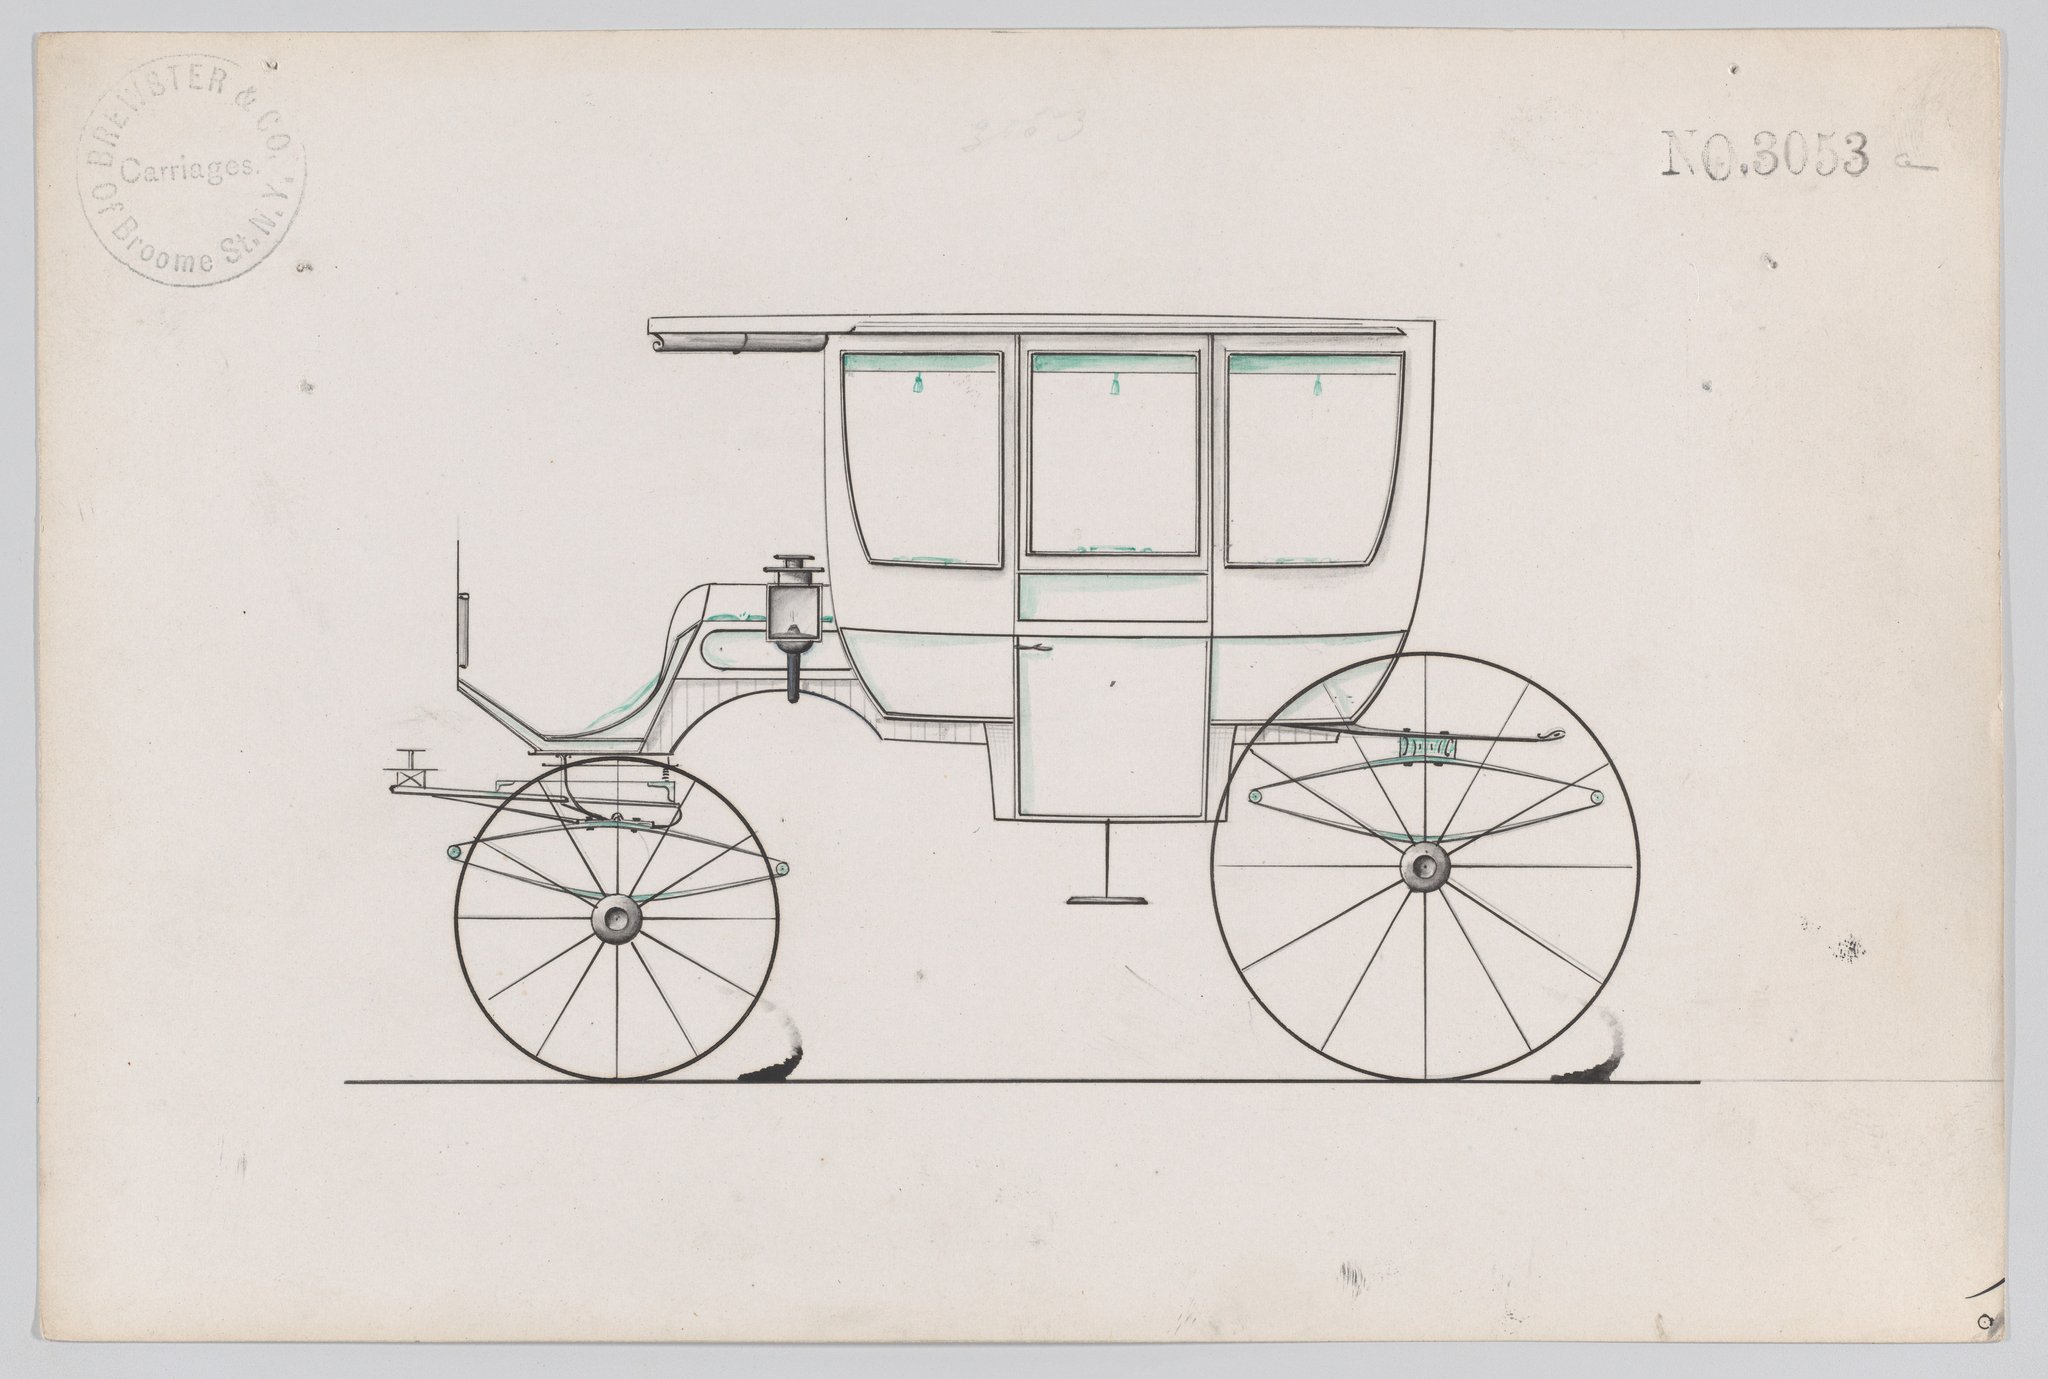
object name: drawing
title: Design for 6 seat Rockaway, no. 3053a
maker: brewster & co.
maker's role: manufacturer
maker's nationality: american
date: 1874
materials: gouache, ink, watercolor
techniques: pen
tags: carriages